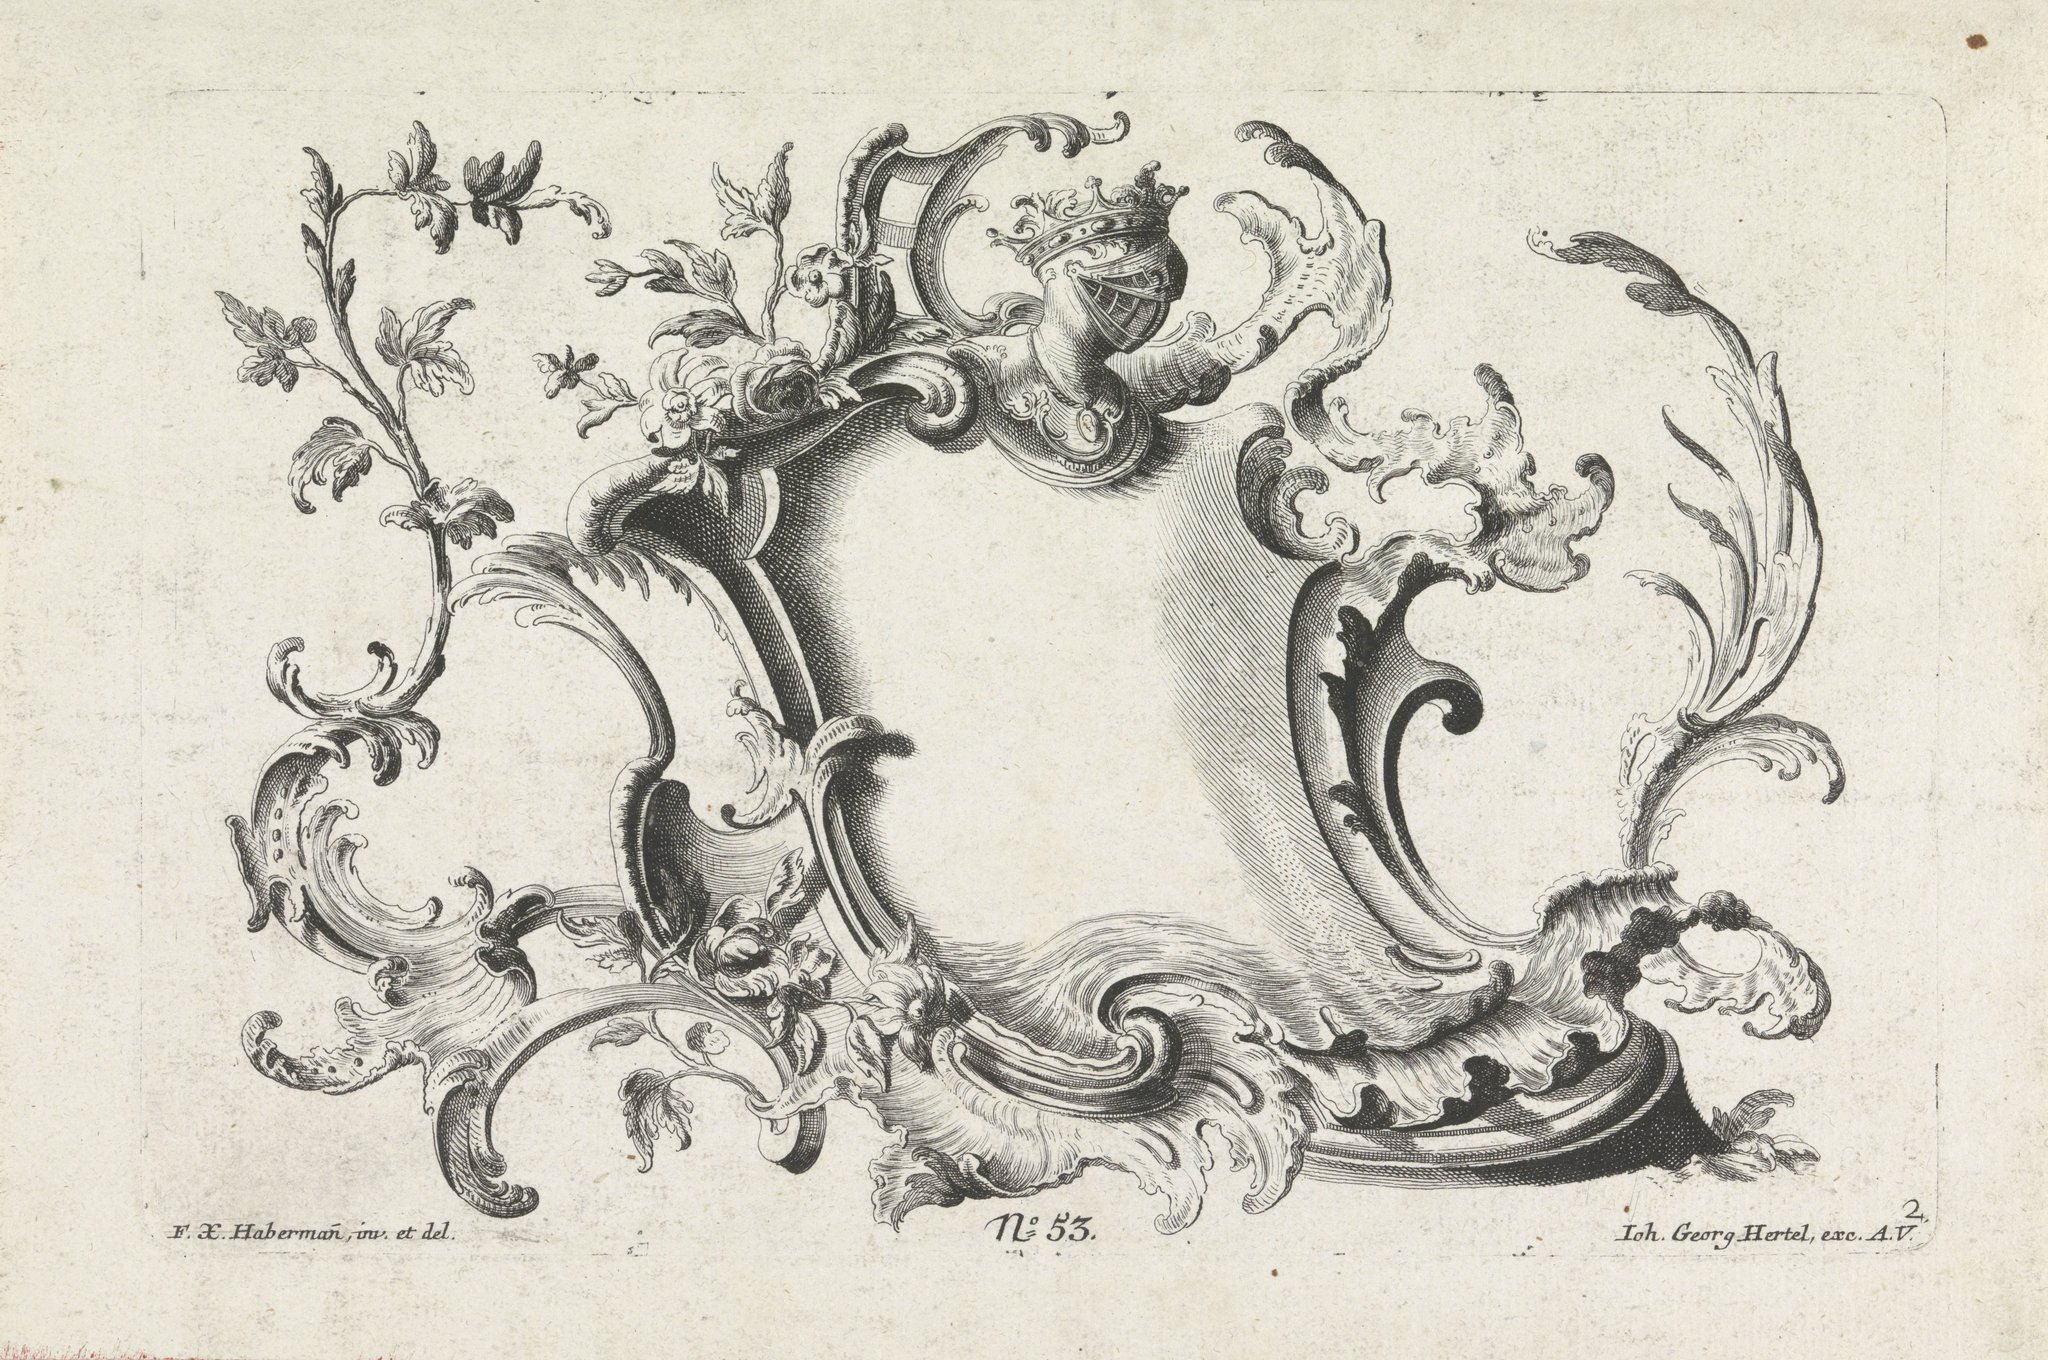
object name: ornament print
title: Cartouche met helm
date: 1731-1775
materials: paper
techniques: etching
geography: augsburg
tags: helmet, rocaille ornament, ornament ~ cartouche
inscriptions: collector's mark: Lugt 2760, collector's mark: Lugt 2228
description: Rocaille cartouche met aan de bovenzijde een helm. Uitgeversnummer 53.